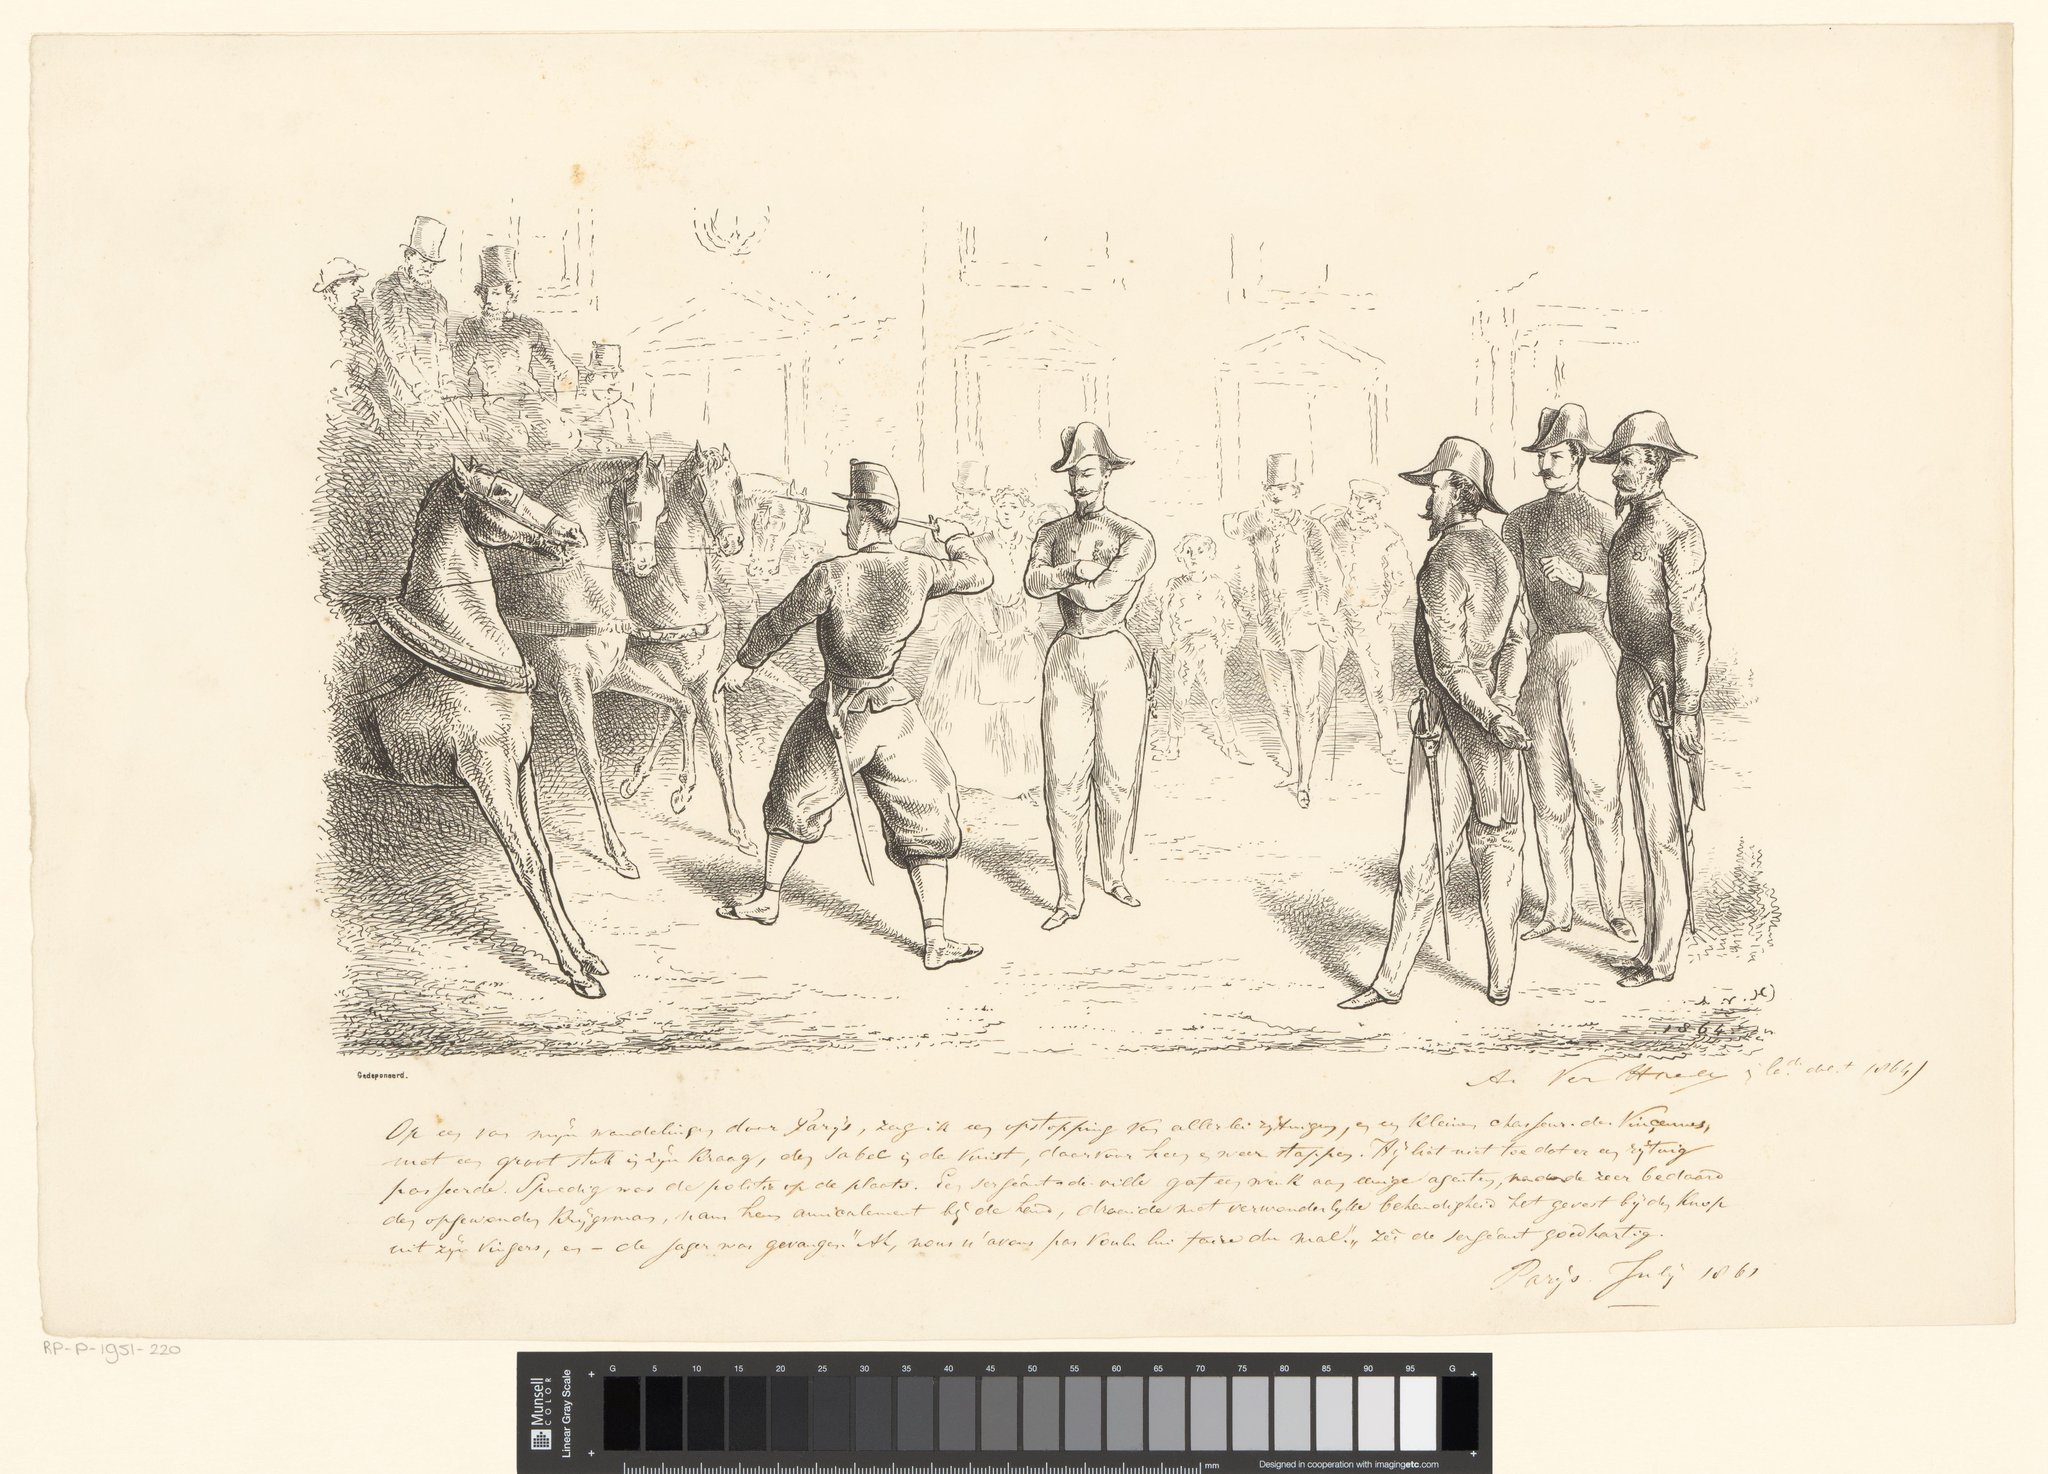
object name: print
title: Man veroorzaakt opstopping te Parijs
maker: alexander ver huell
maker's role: draughtsman, print maker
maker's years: 1822-1897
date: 1864-1866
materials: paper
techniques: lithograph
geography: arnhem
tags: traffic-block, traffic-jam, policeman, constable, paris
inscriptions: : ‘Gedeponeerd.’, collector's mark: Lugt 2228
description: Een man met sabel verspert de weg voor paarden en wagens. Naast de man staat een politieagent die hem zal bedaren. Omstanders en rechts drie politieagenten kijken toe.